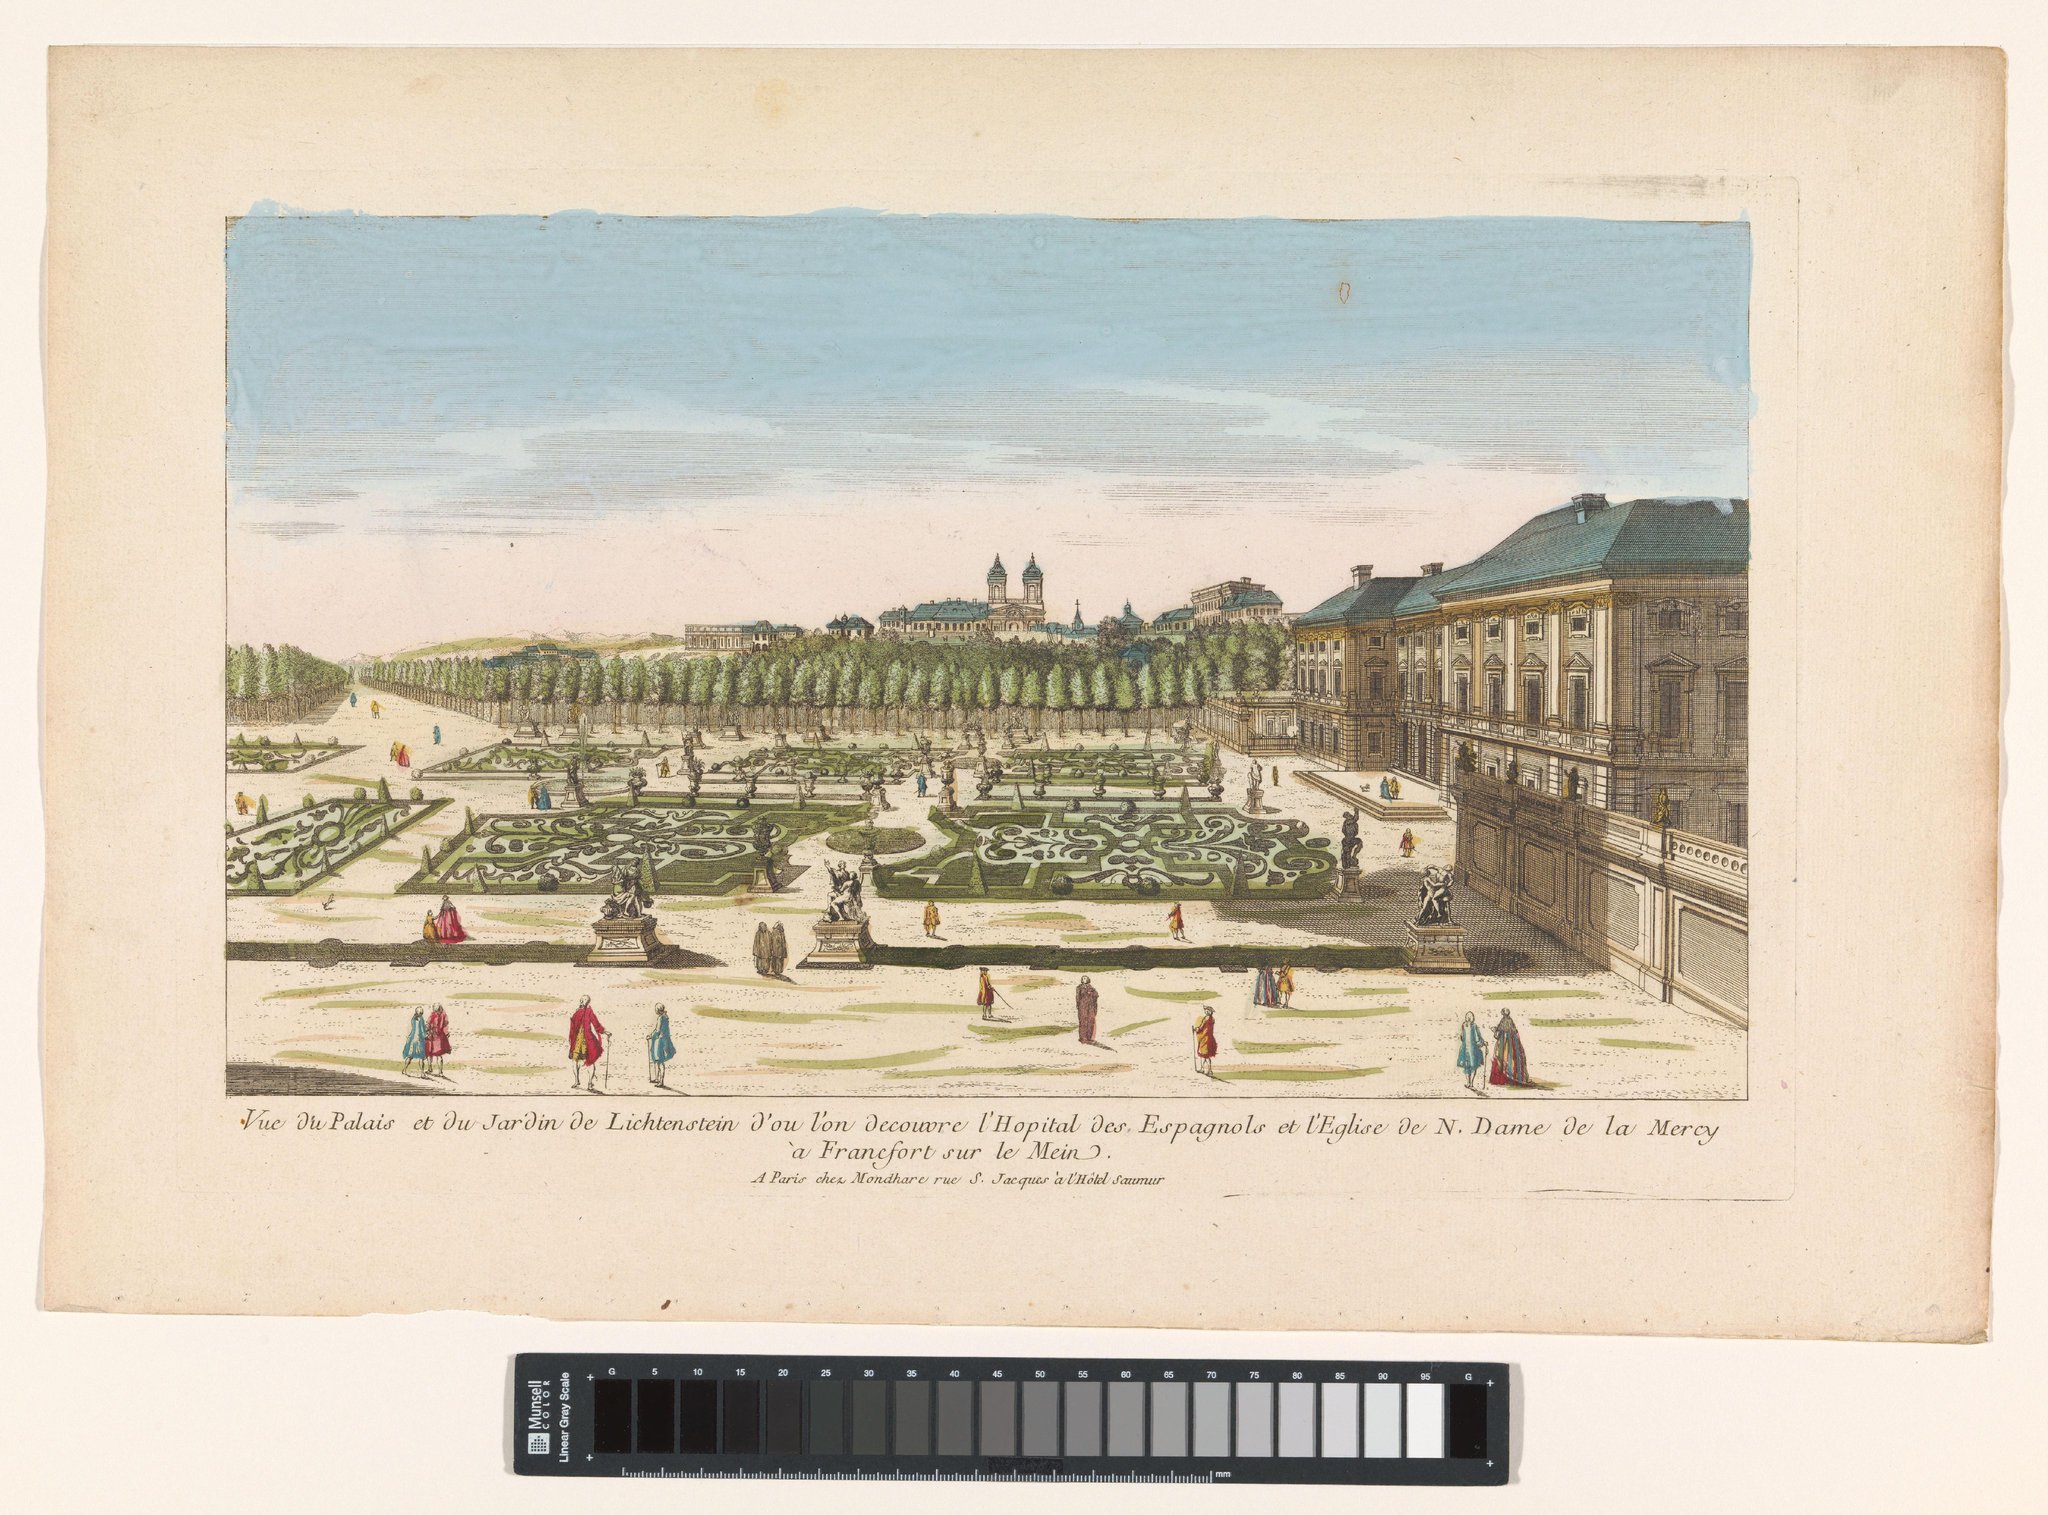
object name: print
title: Gezicht op de tuin en het Gartenpalais Liechtenstein te Wenen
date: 1759-1796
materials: paper, watercolor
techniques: brush, etching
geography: paris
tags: garden, garden fountain, ornamental plants, palace, garden ornaments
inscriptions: collector's mark: Lugt 2166, watermark